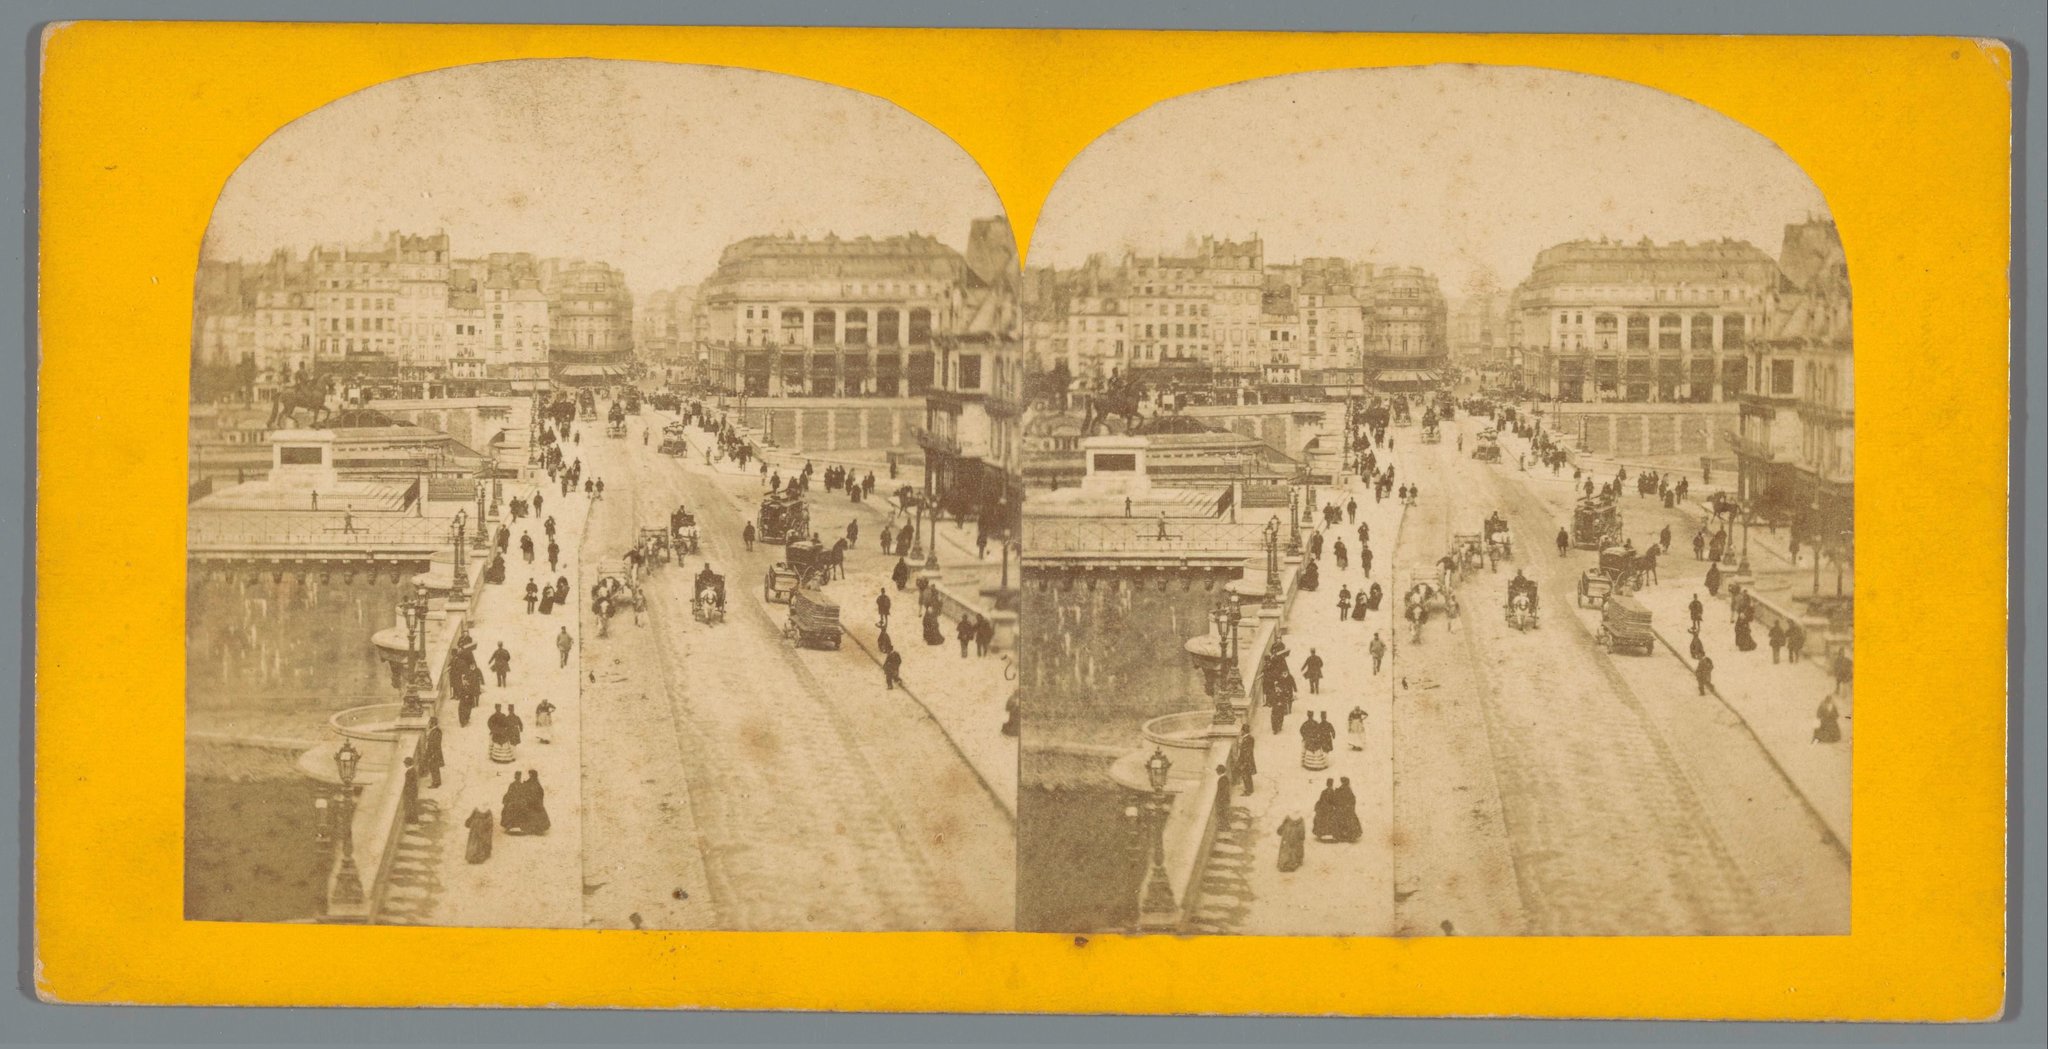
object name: stereograph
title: Gezicht op de Pont Neuf in Parijs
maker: Anonymous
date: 1850-1880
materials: cardboard, photographic support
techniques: albumen print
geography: paris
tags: animal traction, animal-drawn vehicle (carriage etc.), bridge in city across river, canal, etc.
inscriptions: inscription: ‘Pont Neuf gezicht op [...]’